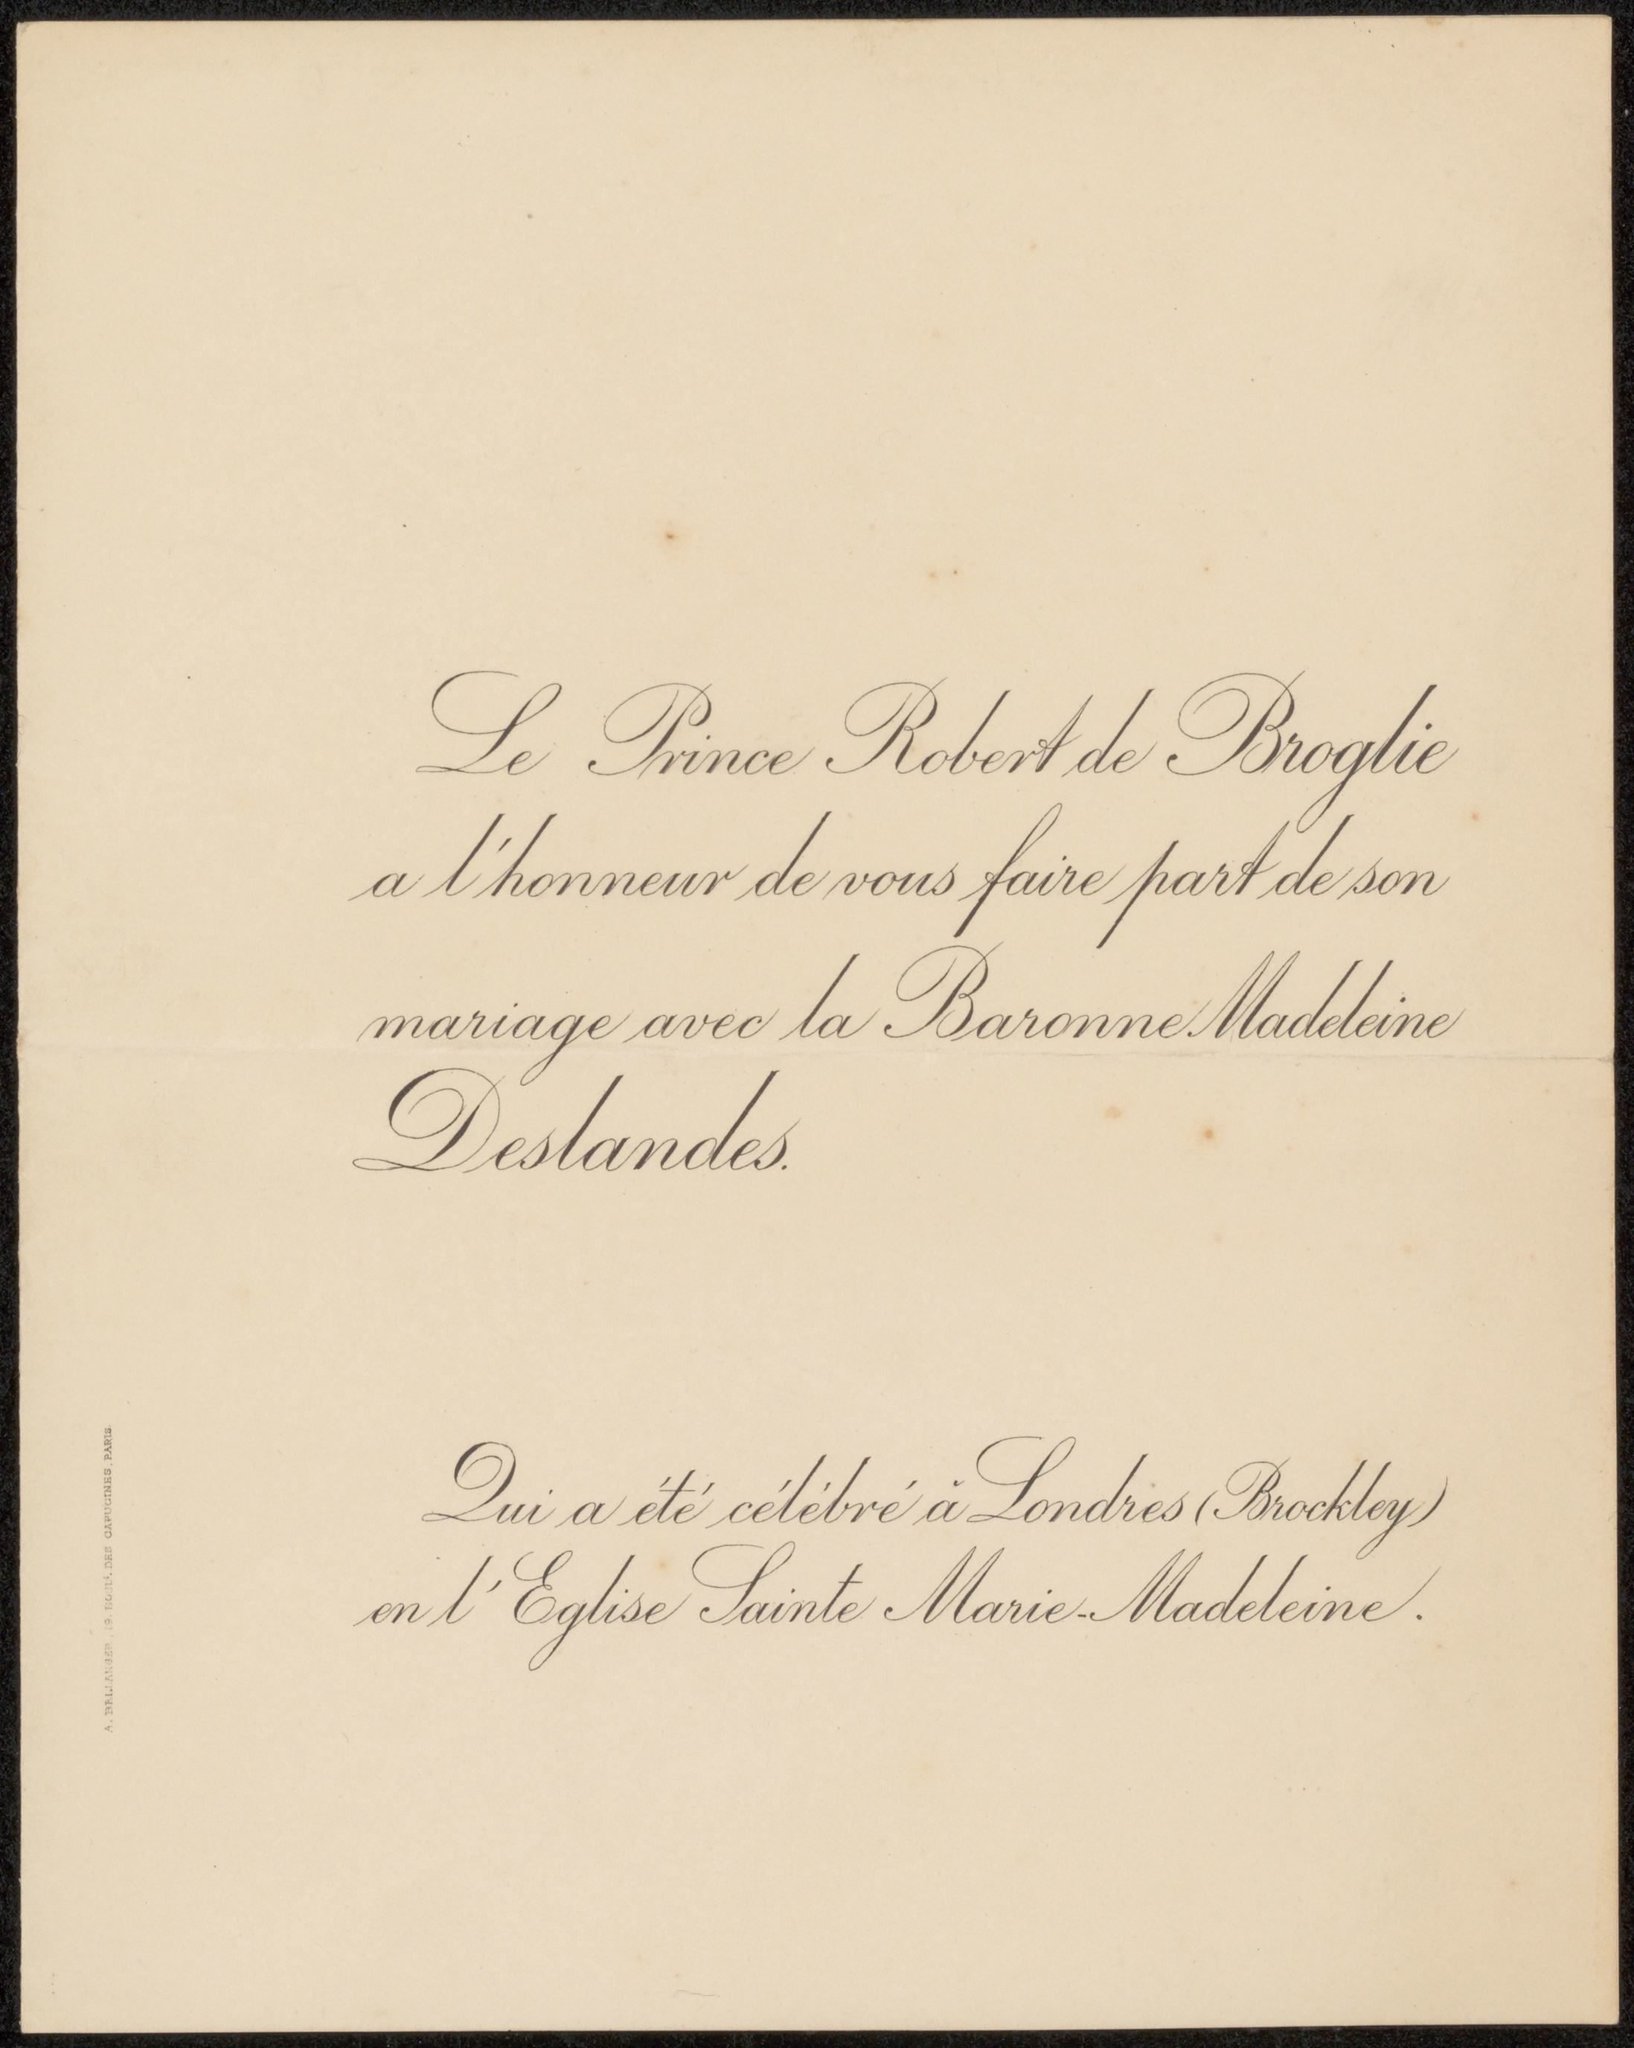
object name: wedding announcement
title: Huwelijksaankondiging aan Philip Zilcken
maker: a. bellanger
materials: paper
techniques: printing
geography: paris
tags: baronne madeleine deslandes, the hague, painter, draughtsman, philip zilcken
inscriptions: collector's mark: ‘RPK’